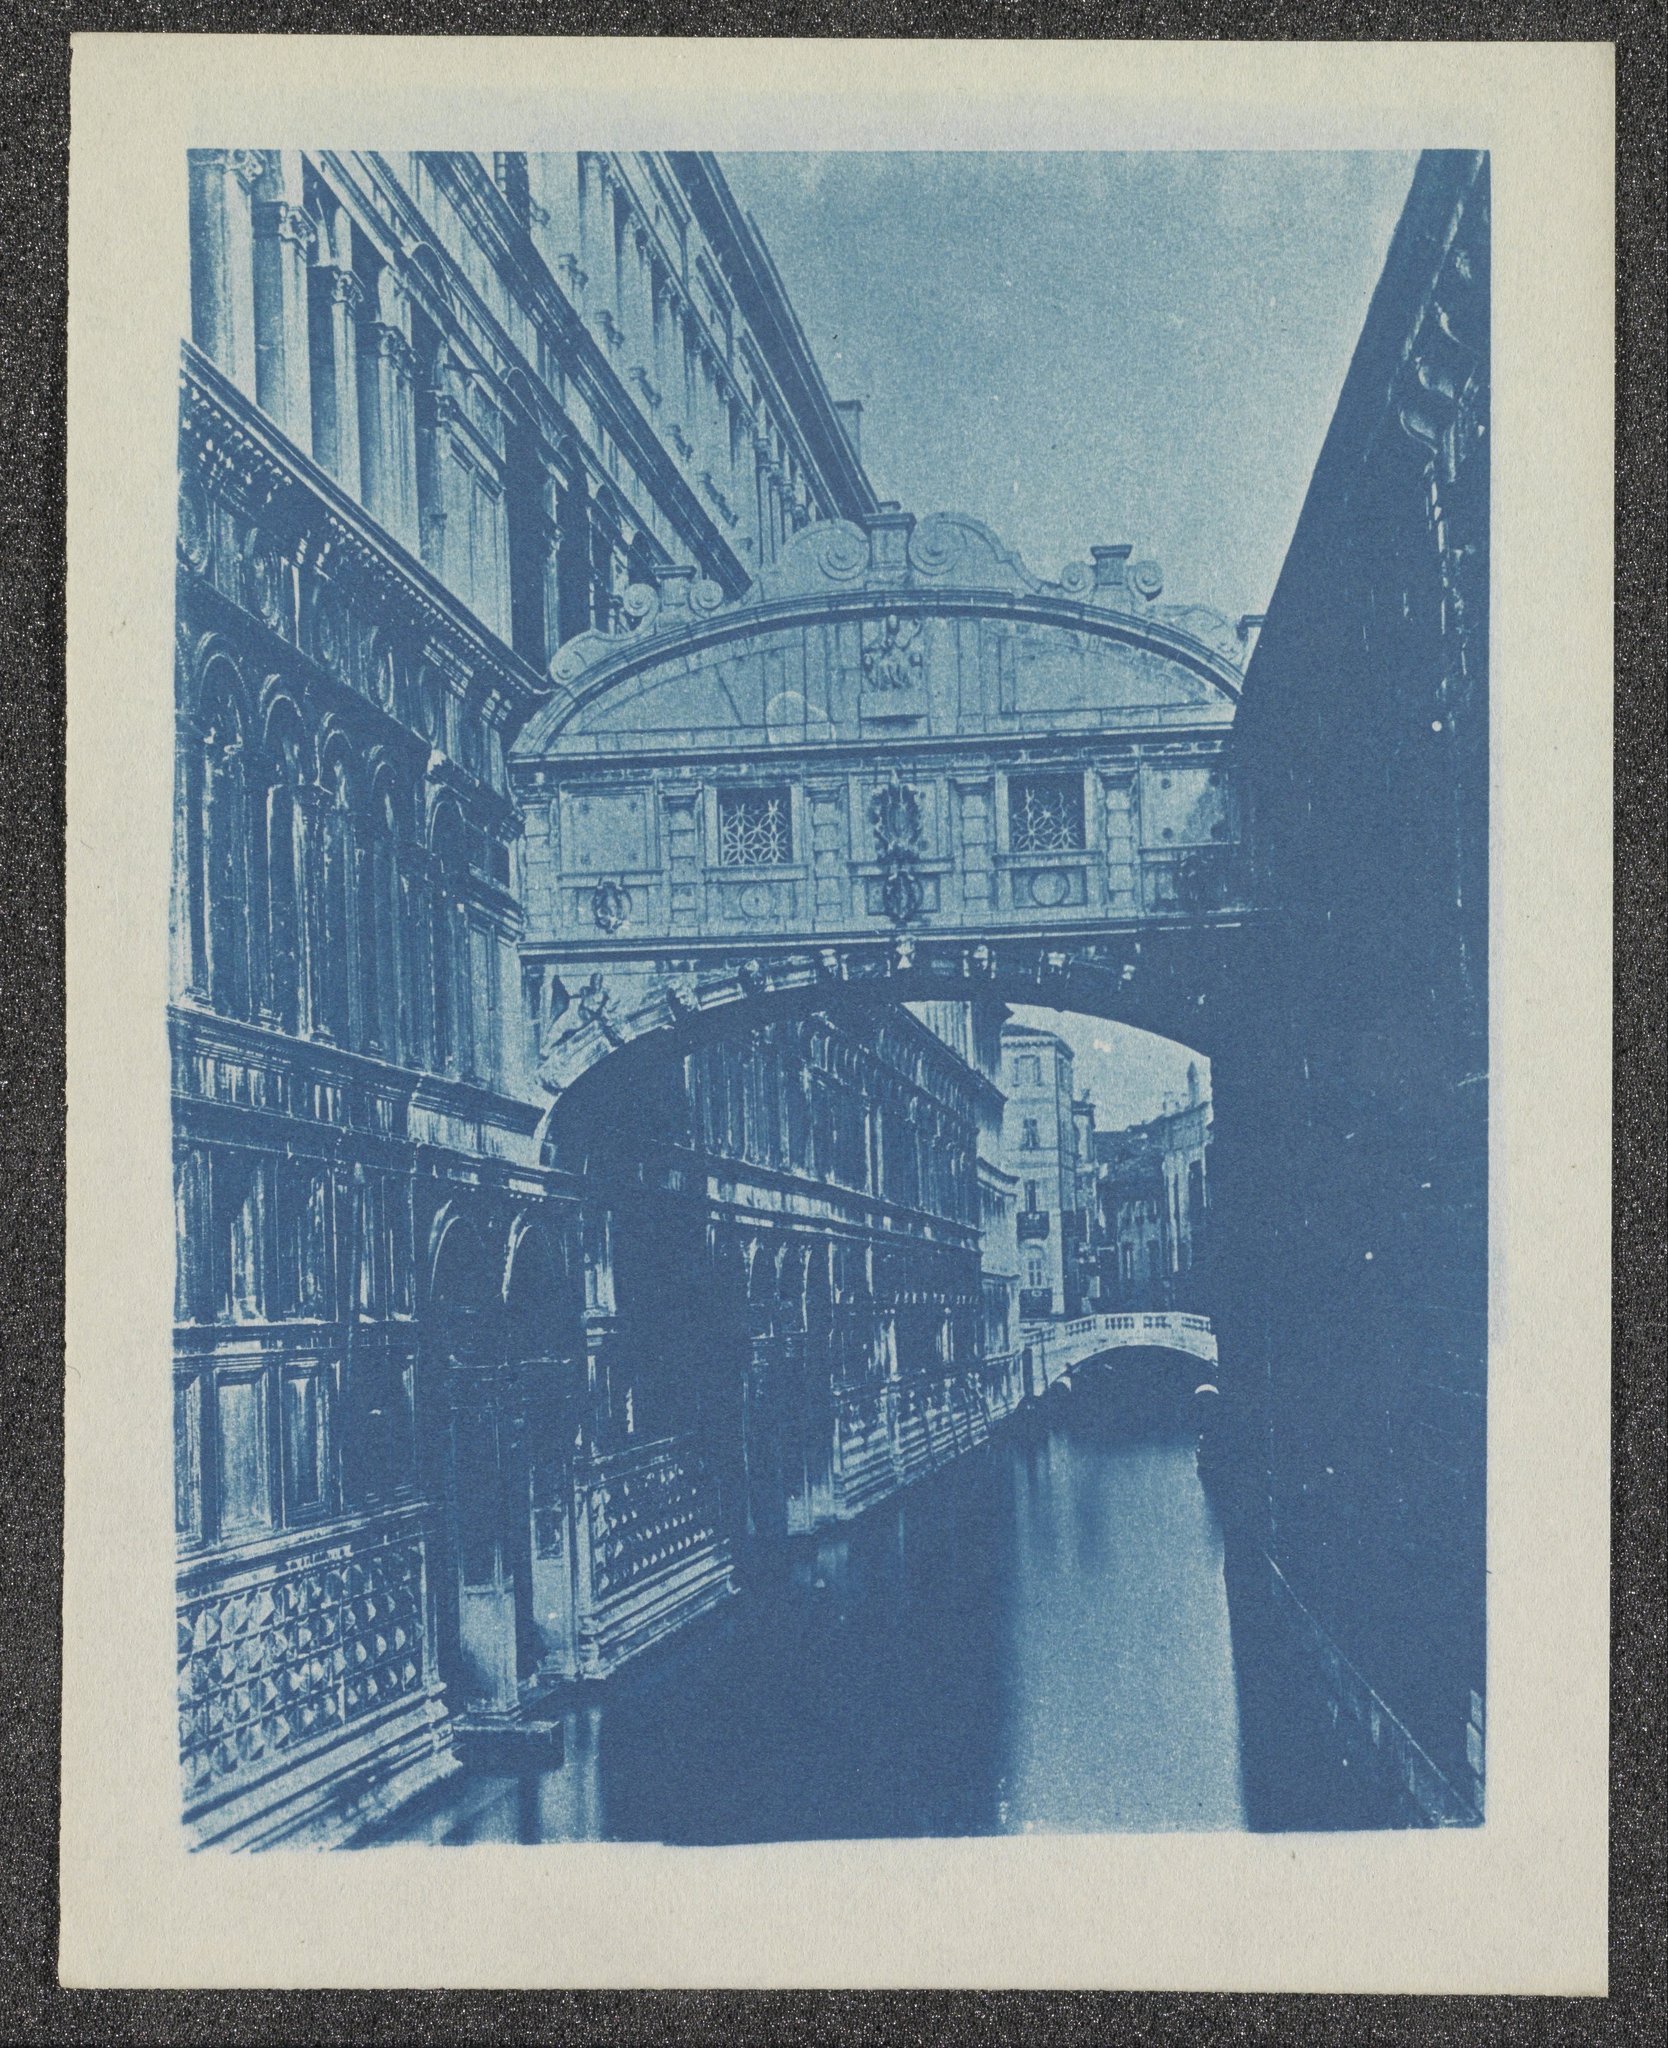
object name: reproduction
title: Fotoreproductie van een foto van de Brug der Zuchten te Venetië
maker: Anonymous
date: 1890-1905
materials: paper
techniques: cyanotype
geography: venice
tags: bridge in city across river, canal, etc.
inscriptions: inscription: ‘Bridge of Sighs/ connecting Doges Pal-/ ace and the prison/ Venice/ 3153’